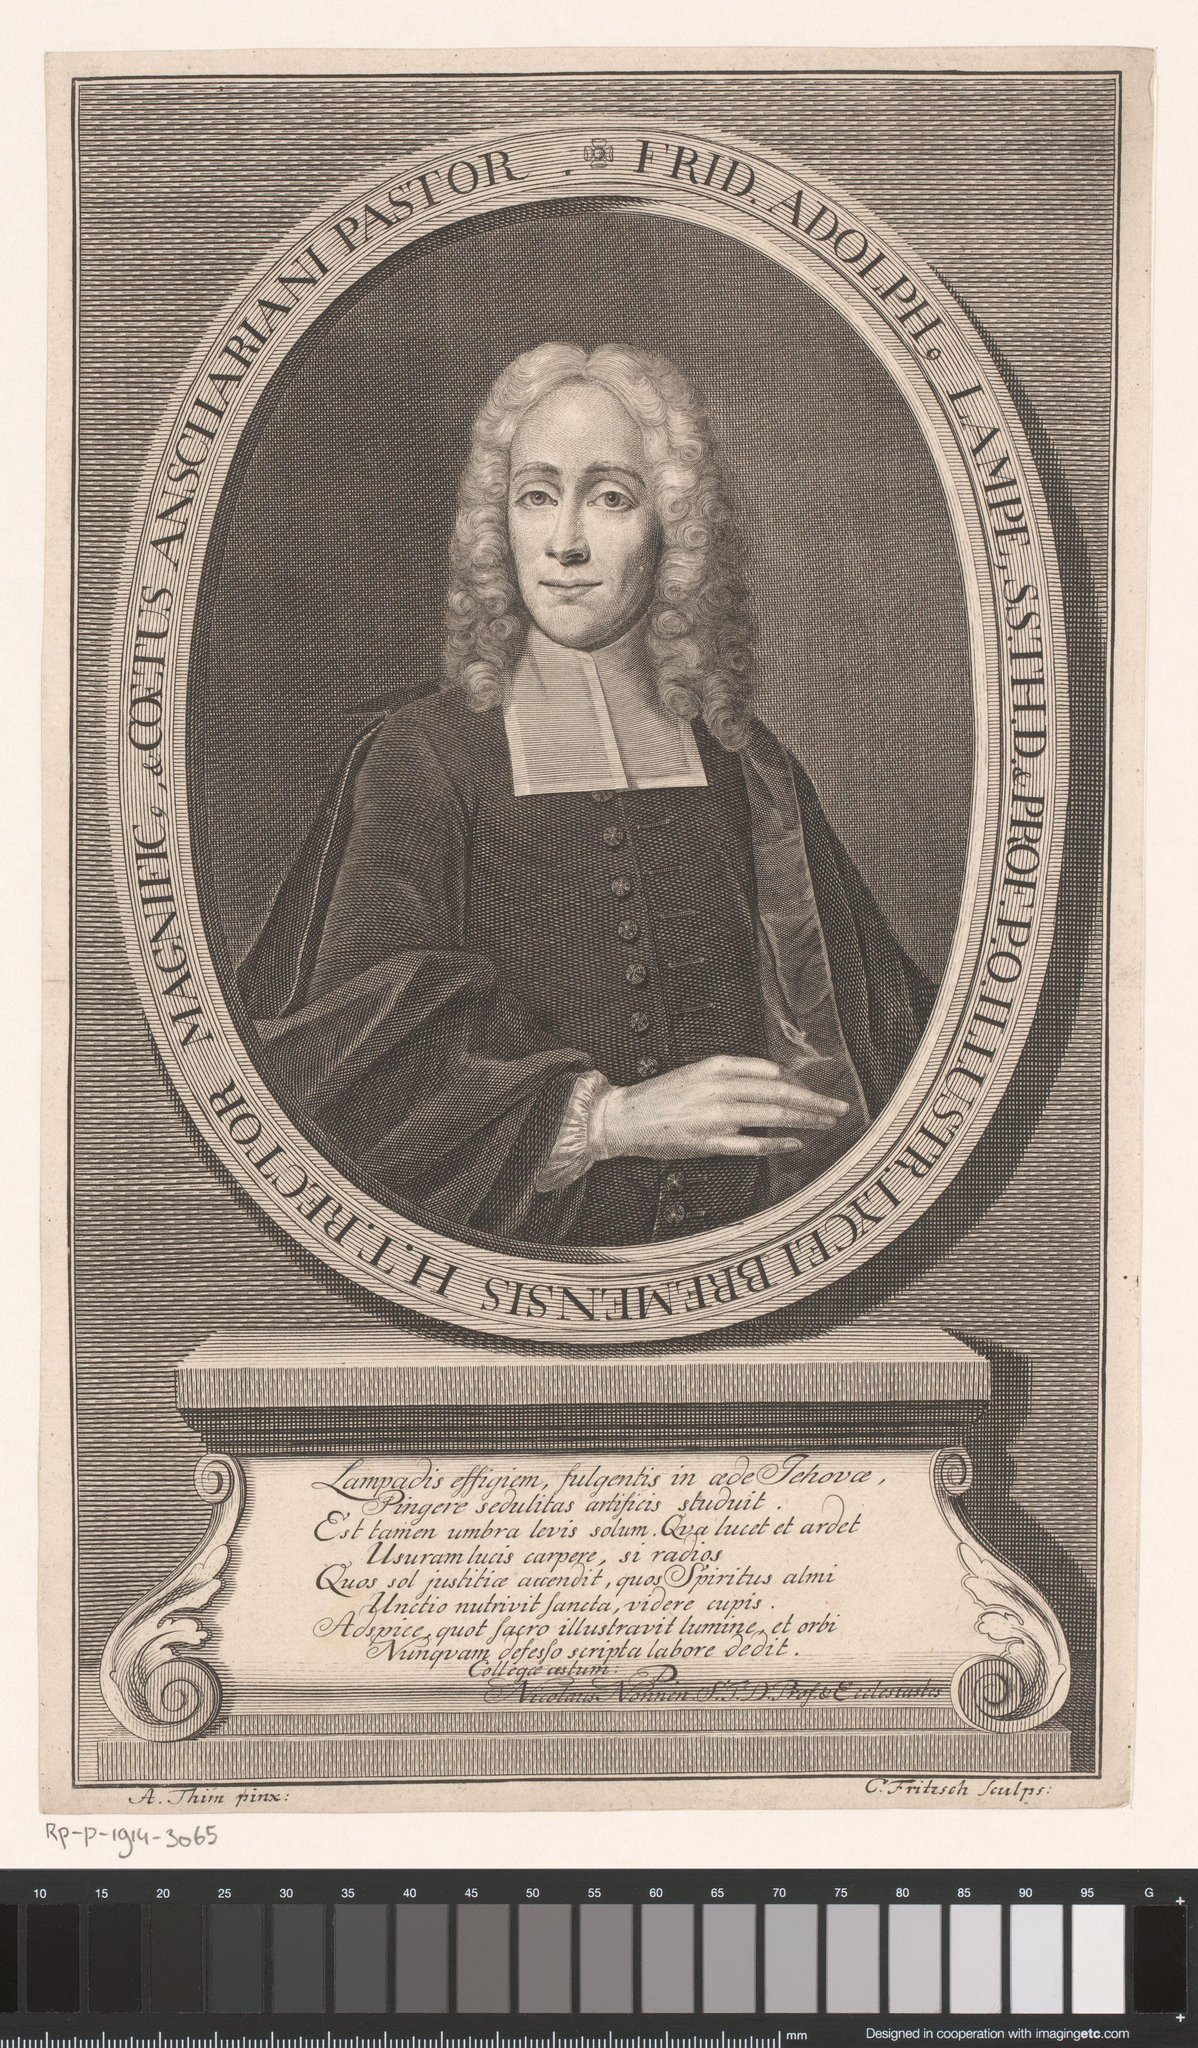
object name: print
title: Portret van Friedrich Adolph Lampe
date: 1705-1729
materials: paper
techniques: engraving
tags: ornament ~ medallion, historical persons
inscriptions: collector's mark: Lugt 2228